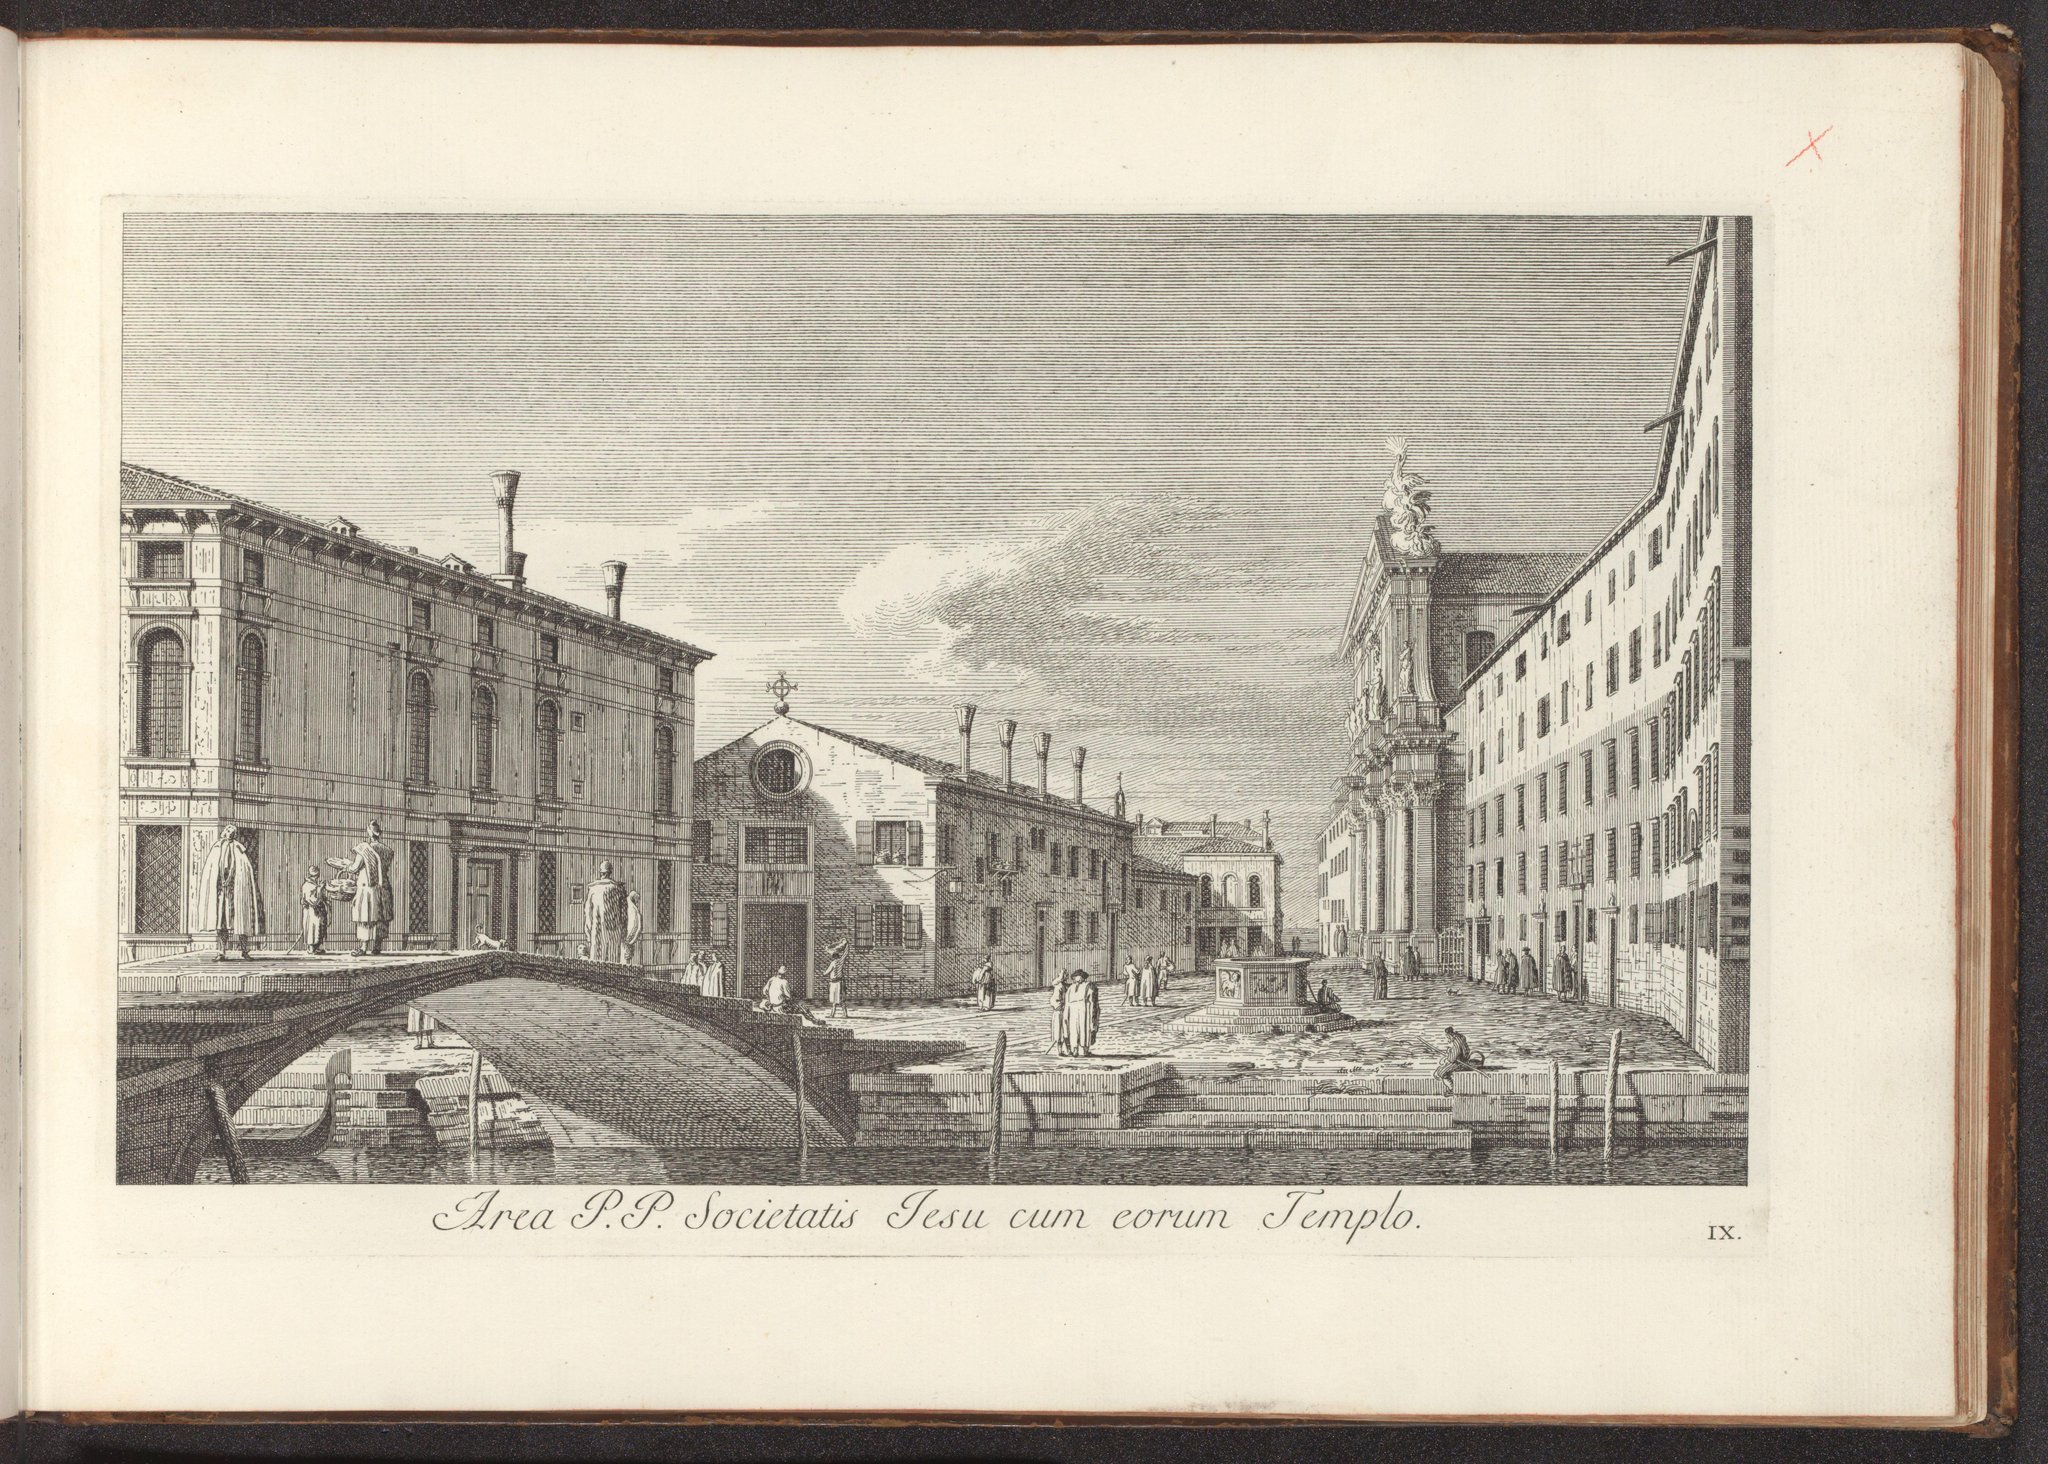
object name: album leaf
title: Urbis Venetiarum prospectus celebriores, ex Antonii Canal tabulis XXXVIII aere expressi ab Antonio Vissentini in partes tres distributi. pars tertia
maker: antonio visentini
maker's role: draughtsman, print maker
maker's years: 1688-1782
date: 1742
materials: paper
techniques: etching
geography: venice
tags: square, place, circus, etc., city-view, and landscape with man-made constructions, canal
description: Gezicht op Campo dei Gesuiti te Venetië, met links Palazzo Zen en rechts de Chiesa di Santa Maria Assunta detta I Gesuiti. De prent maakt deel uit van een album.